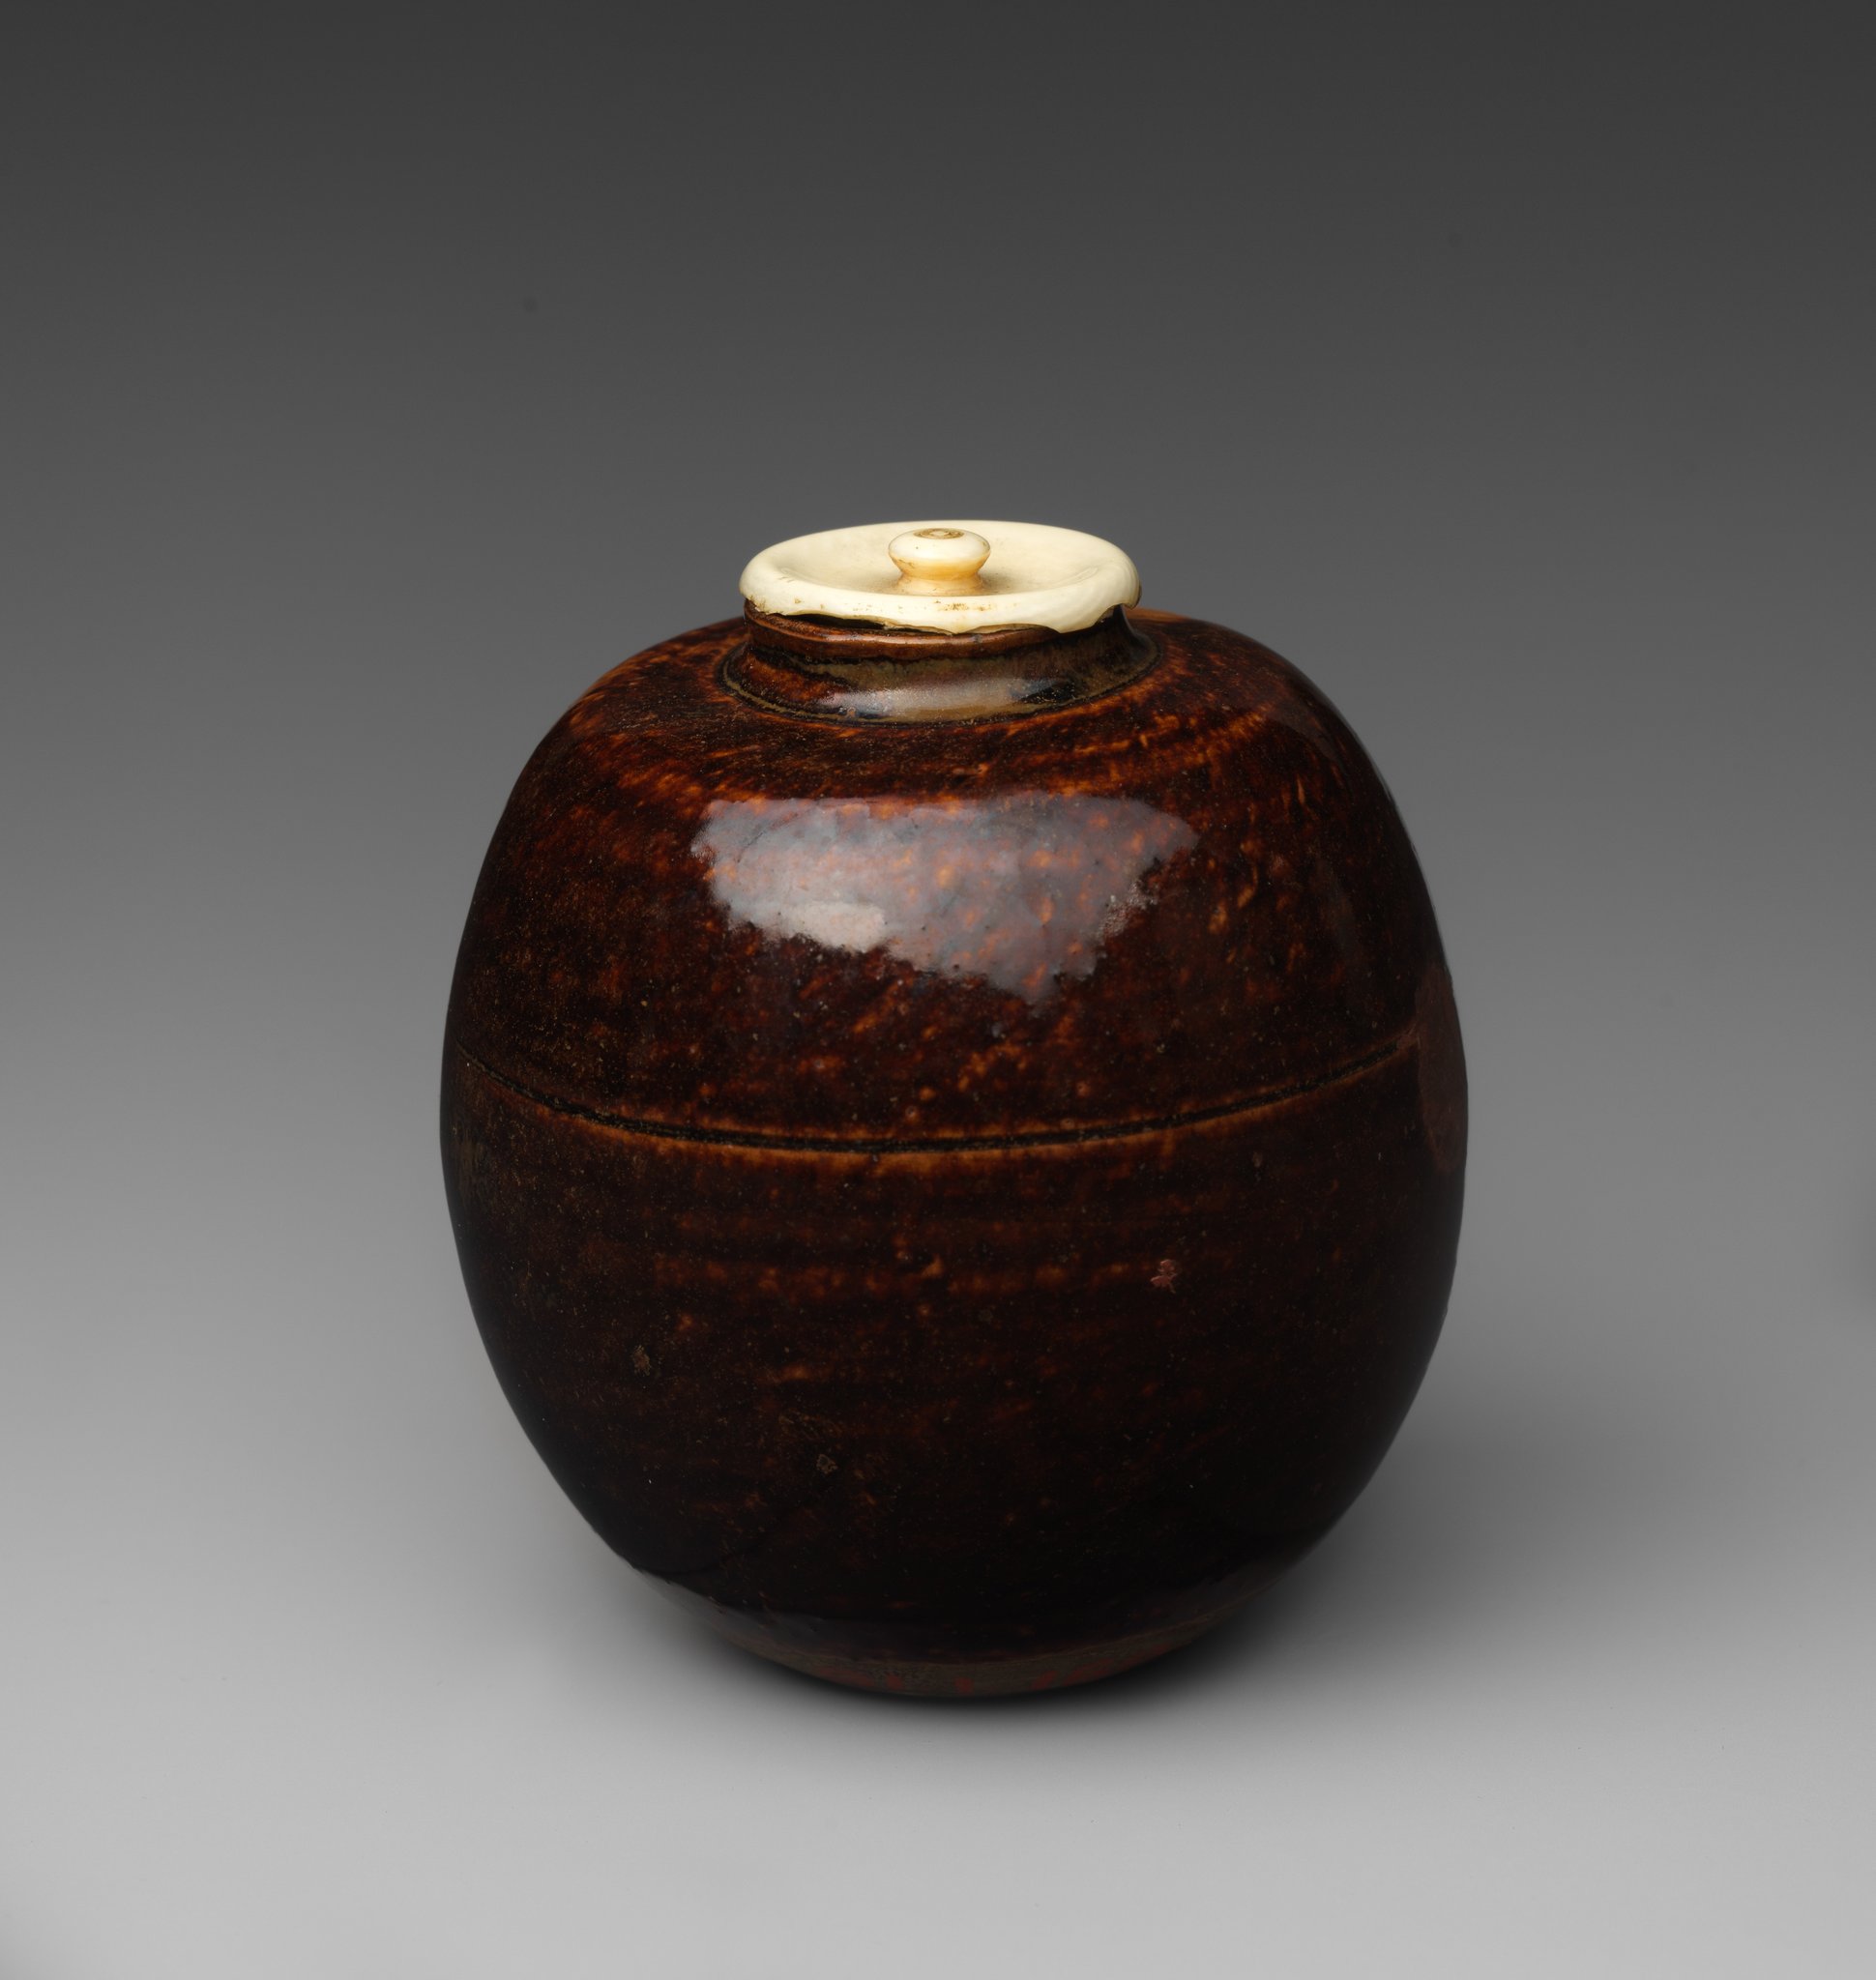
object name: tea jar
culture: japanese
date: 1701-1800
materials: clay, glaze